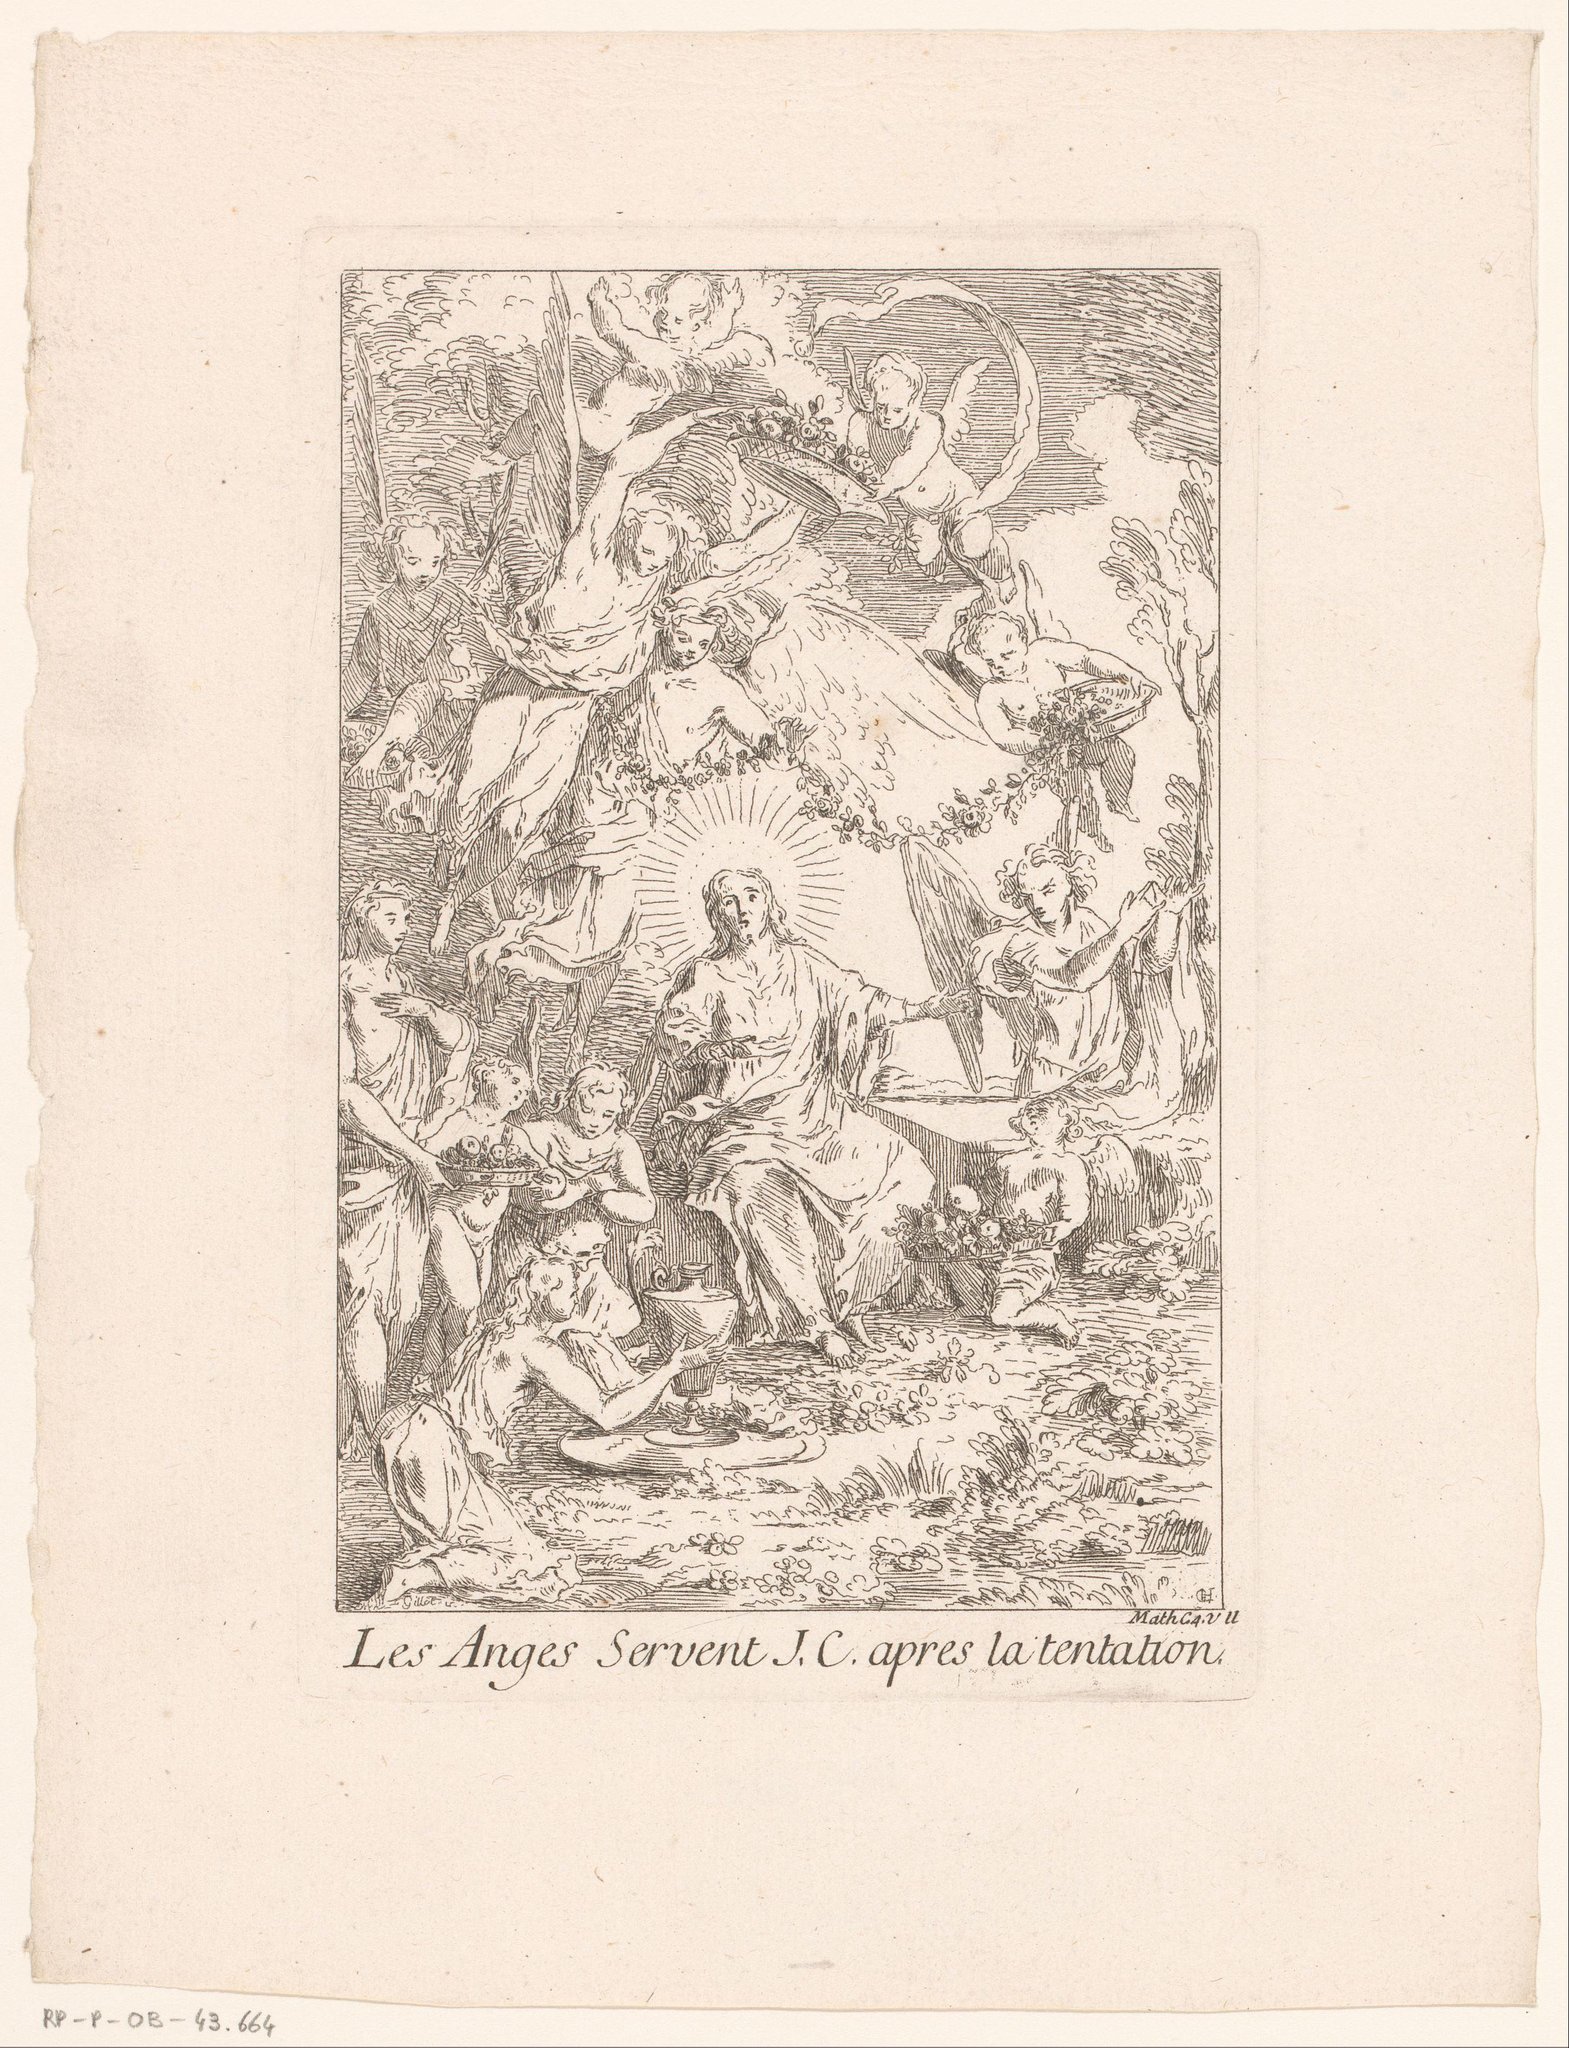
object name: print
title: Christus met engelen in de wildernis na de verzoeking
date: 1705-1732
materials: paper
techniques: etching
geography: paris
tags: 'command these stones to become loaves of bread' ~ temptation of christ in the wilderness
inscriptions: collector's mark: Lugt 2228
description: Maakt deel uit van een serie met zestig prenten met als thema het leven van Christus.